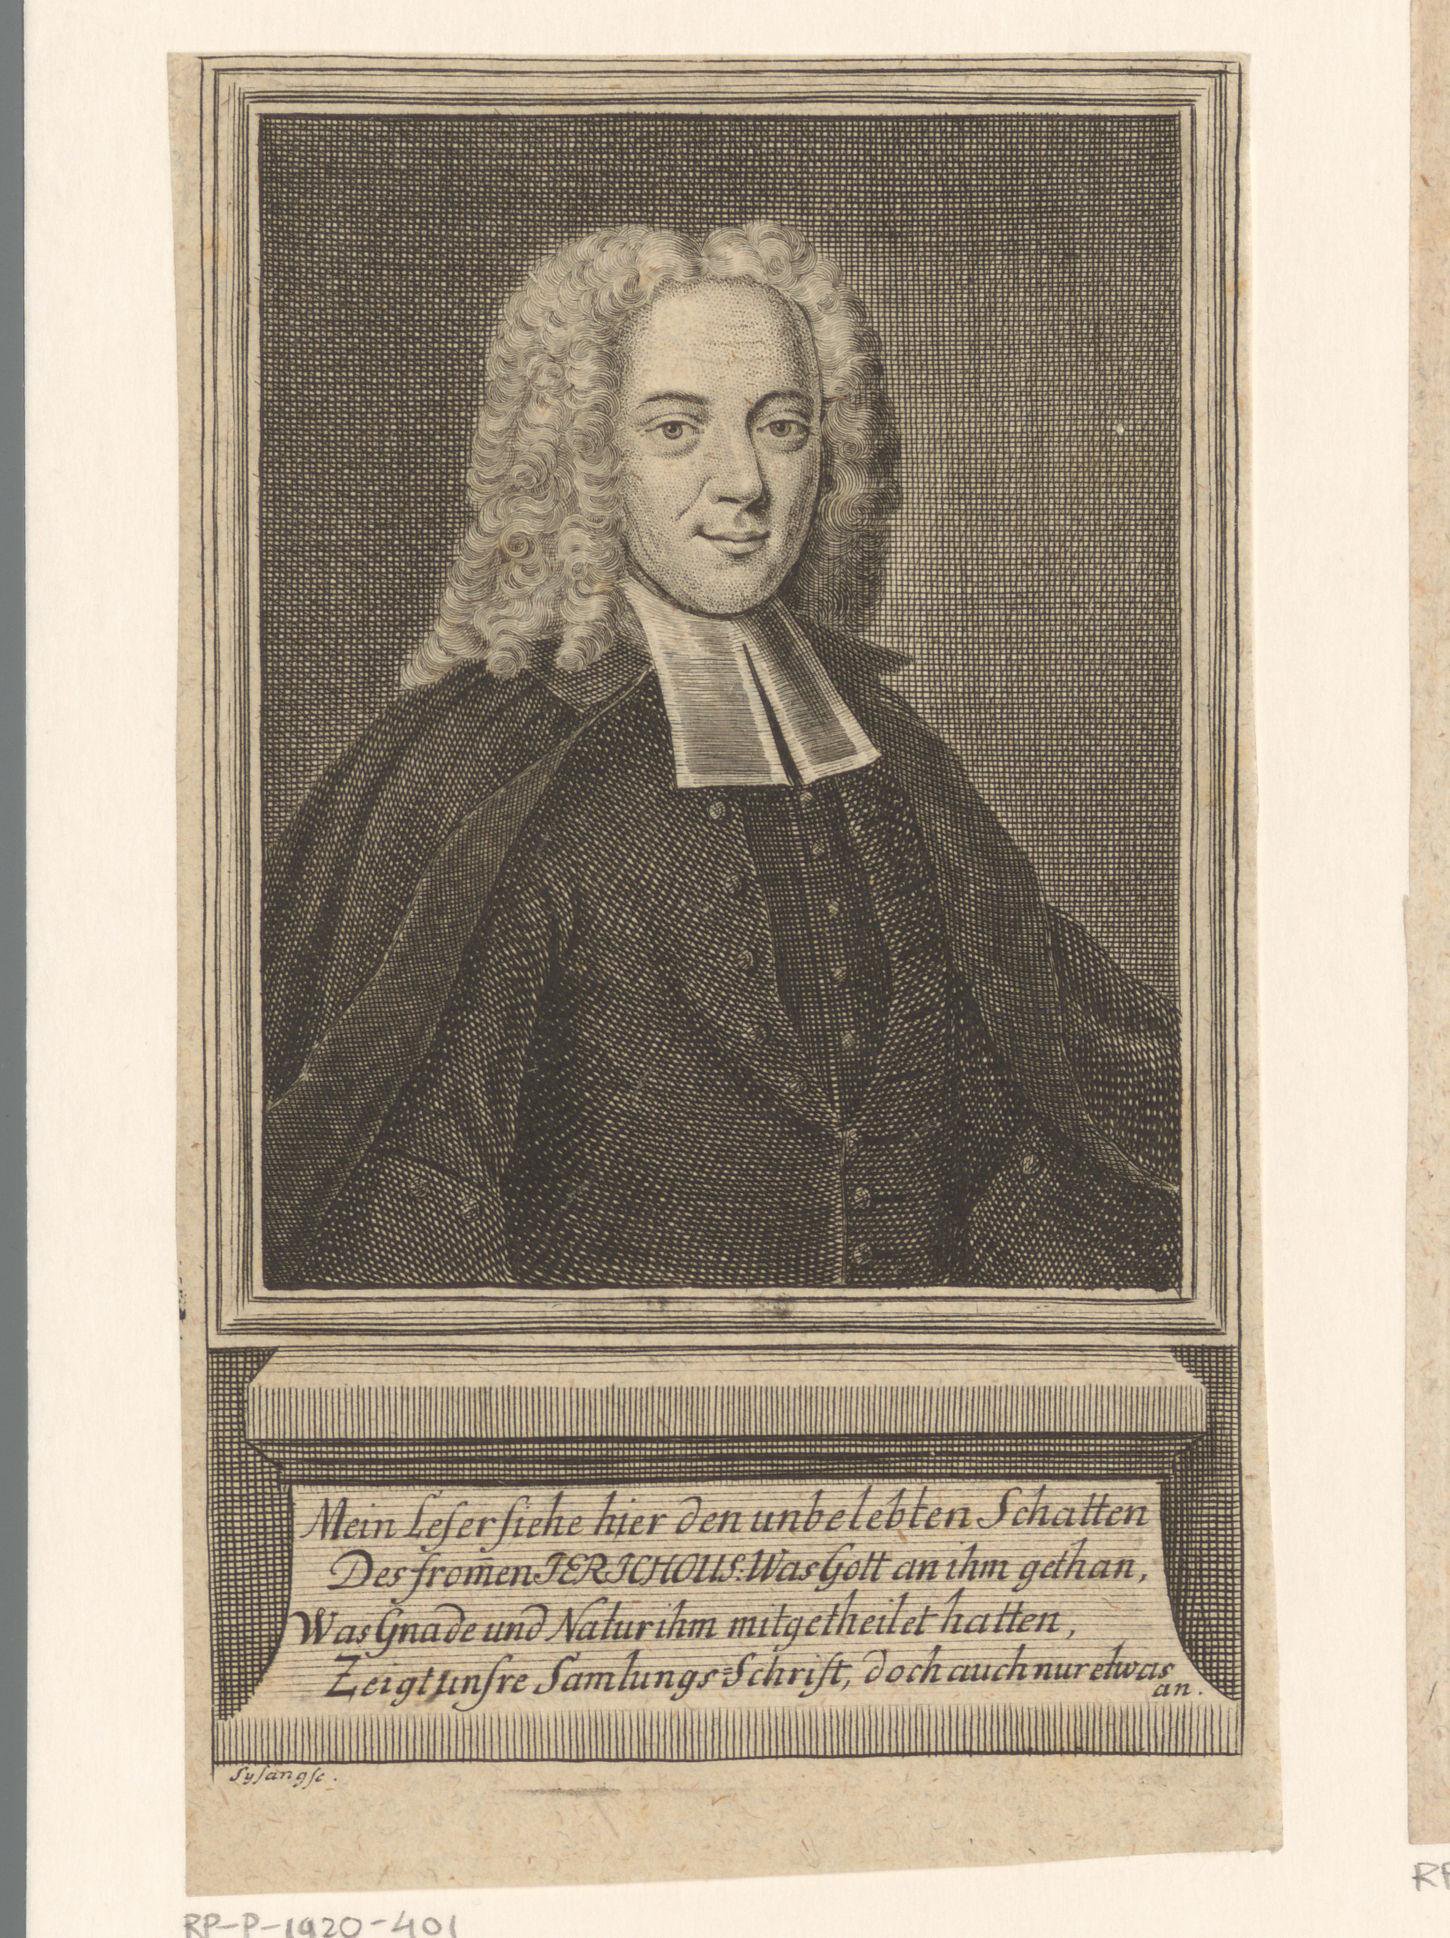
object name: print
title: Portret van Traugott Immanuel Jerichow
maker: johann christoph sysang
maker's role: print maker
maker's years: 1703-1757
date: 1725-1757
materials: paper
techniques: engraving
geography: germany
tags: historical persons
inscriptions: collector's mark: Lugt 2228